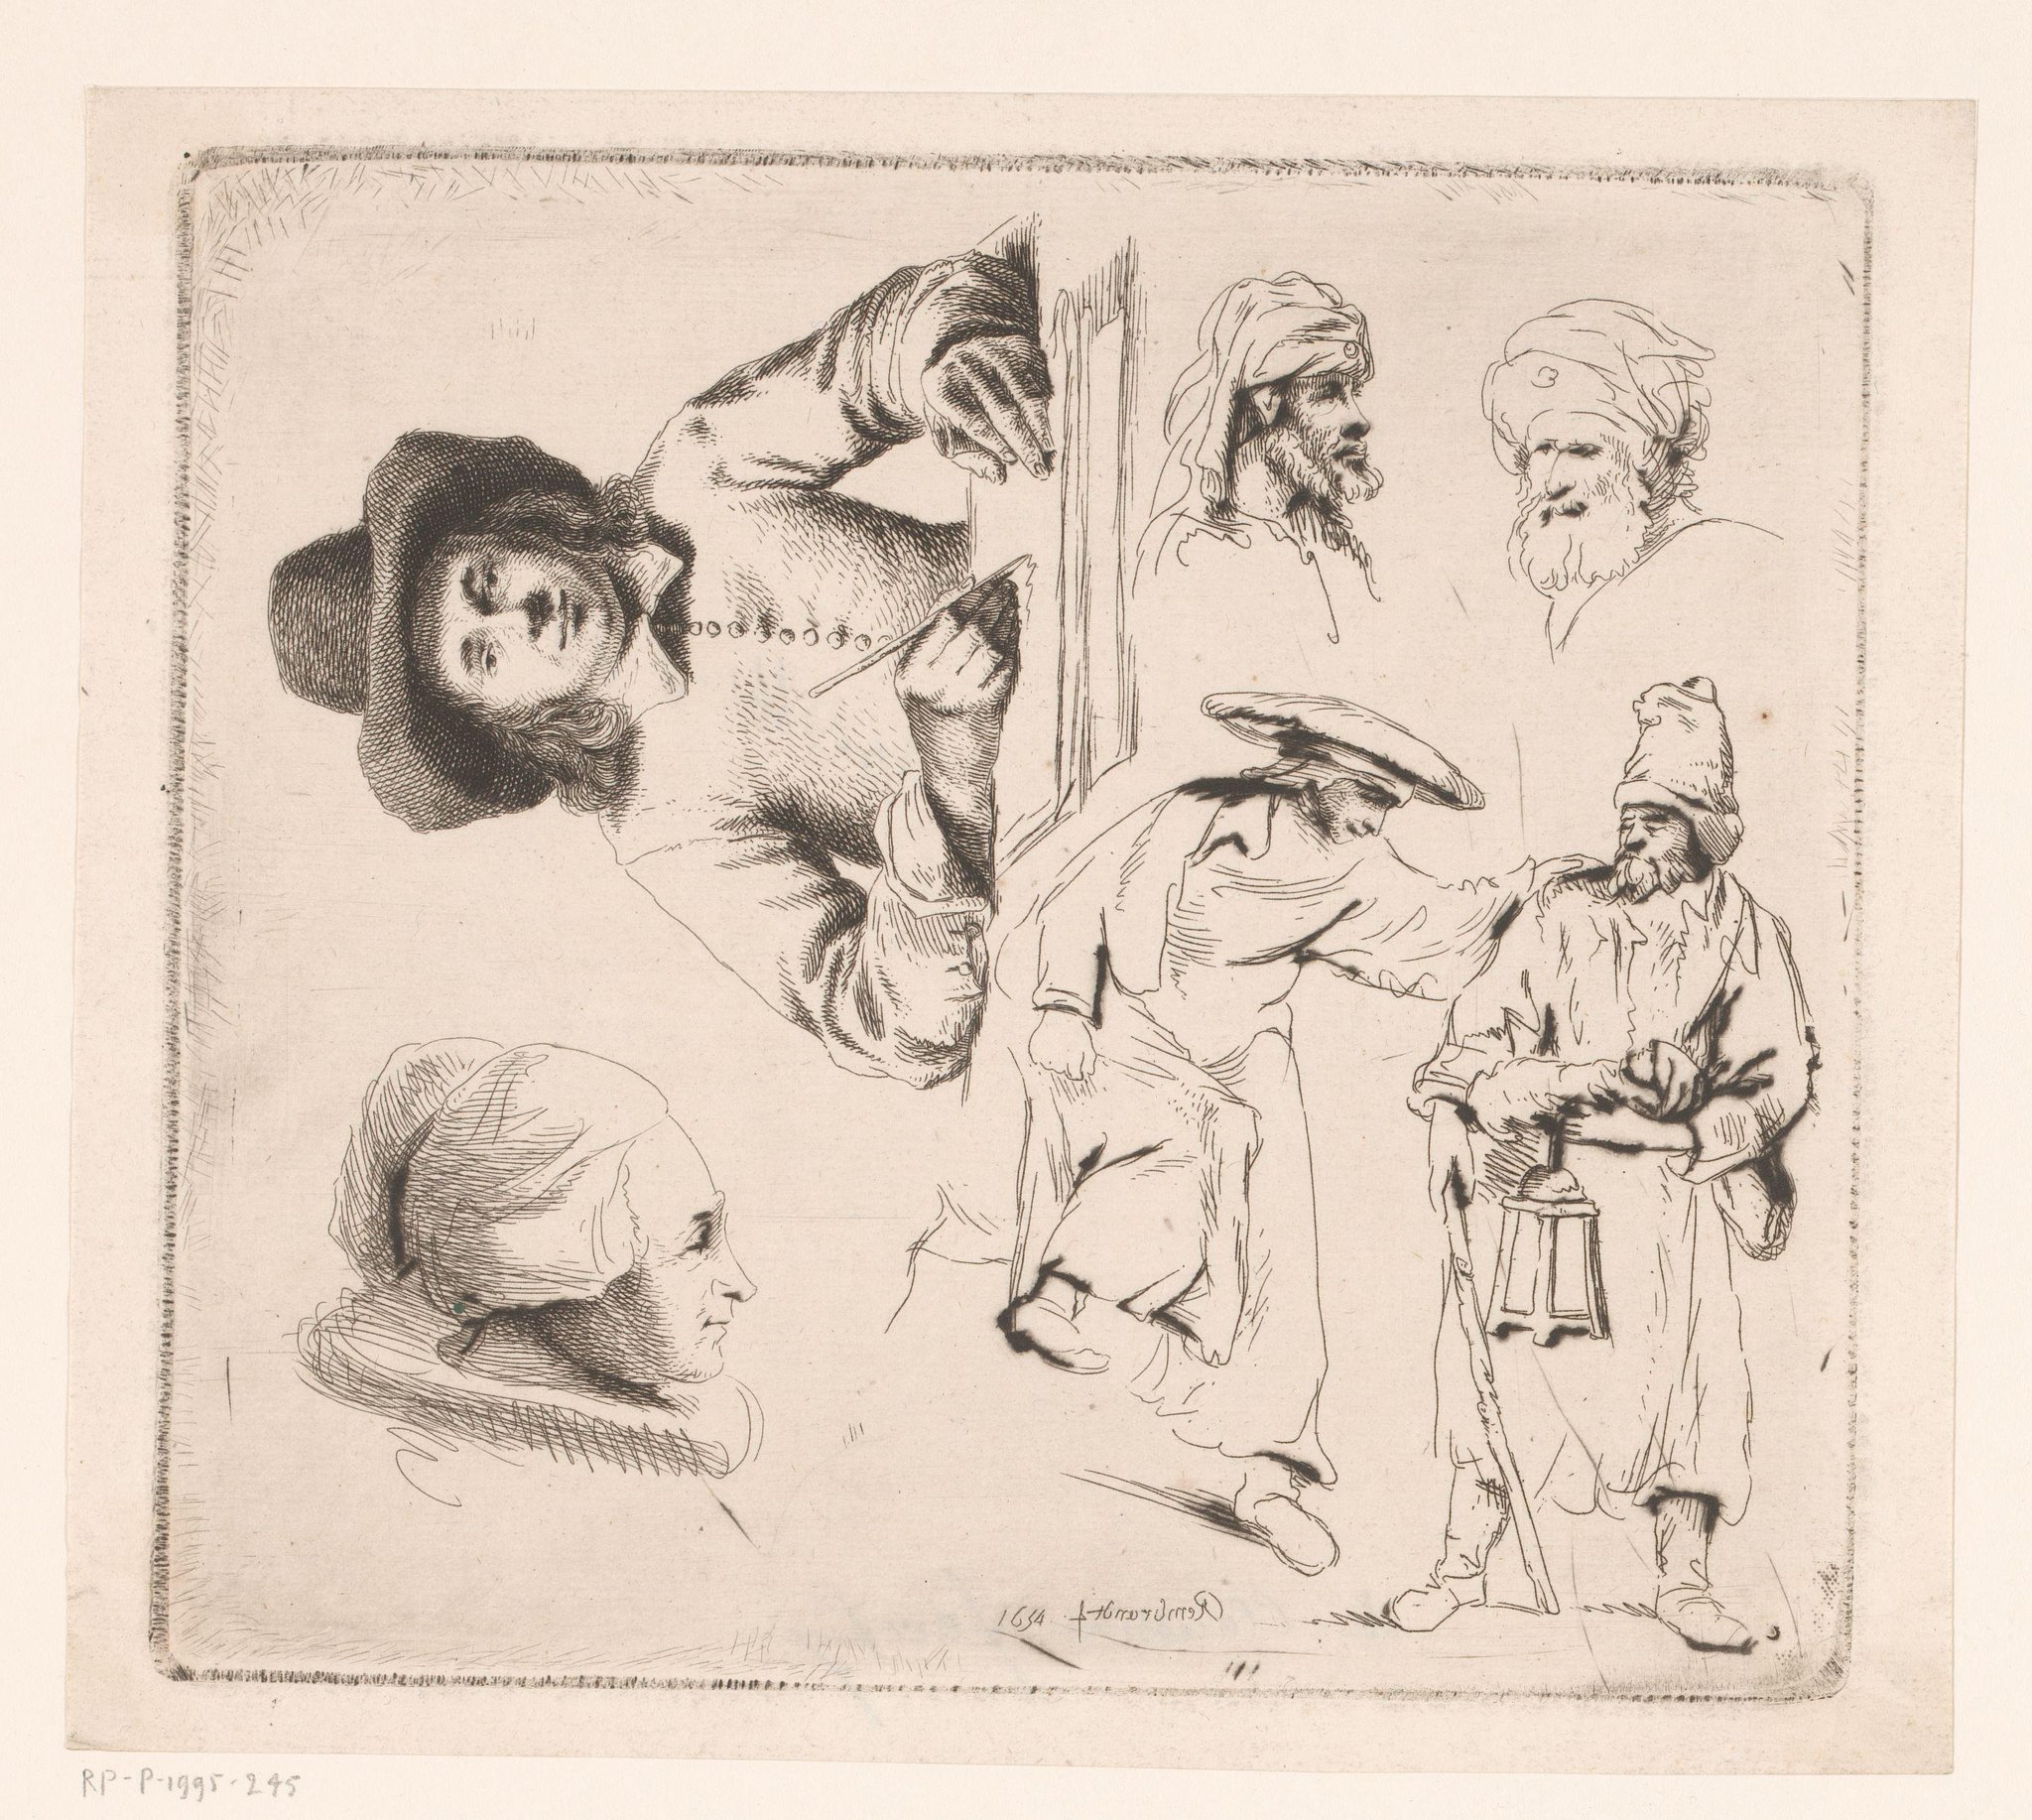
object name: print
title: Compositie met schrijvende man, hoofd van een vrouw en vier mannelijke figuren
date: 1805-1844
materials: paper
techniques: drypoint, engraving, etching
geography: france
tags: adult man, lantern, writing and letters, head (human) - aa - female human figure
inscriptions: watermark